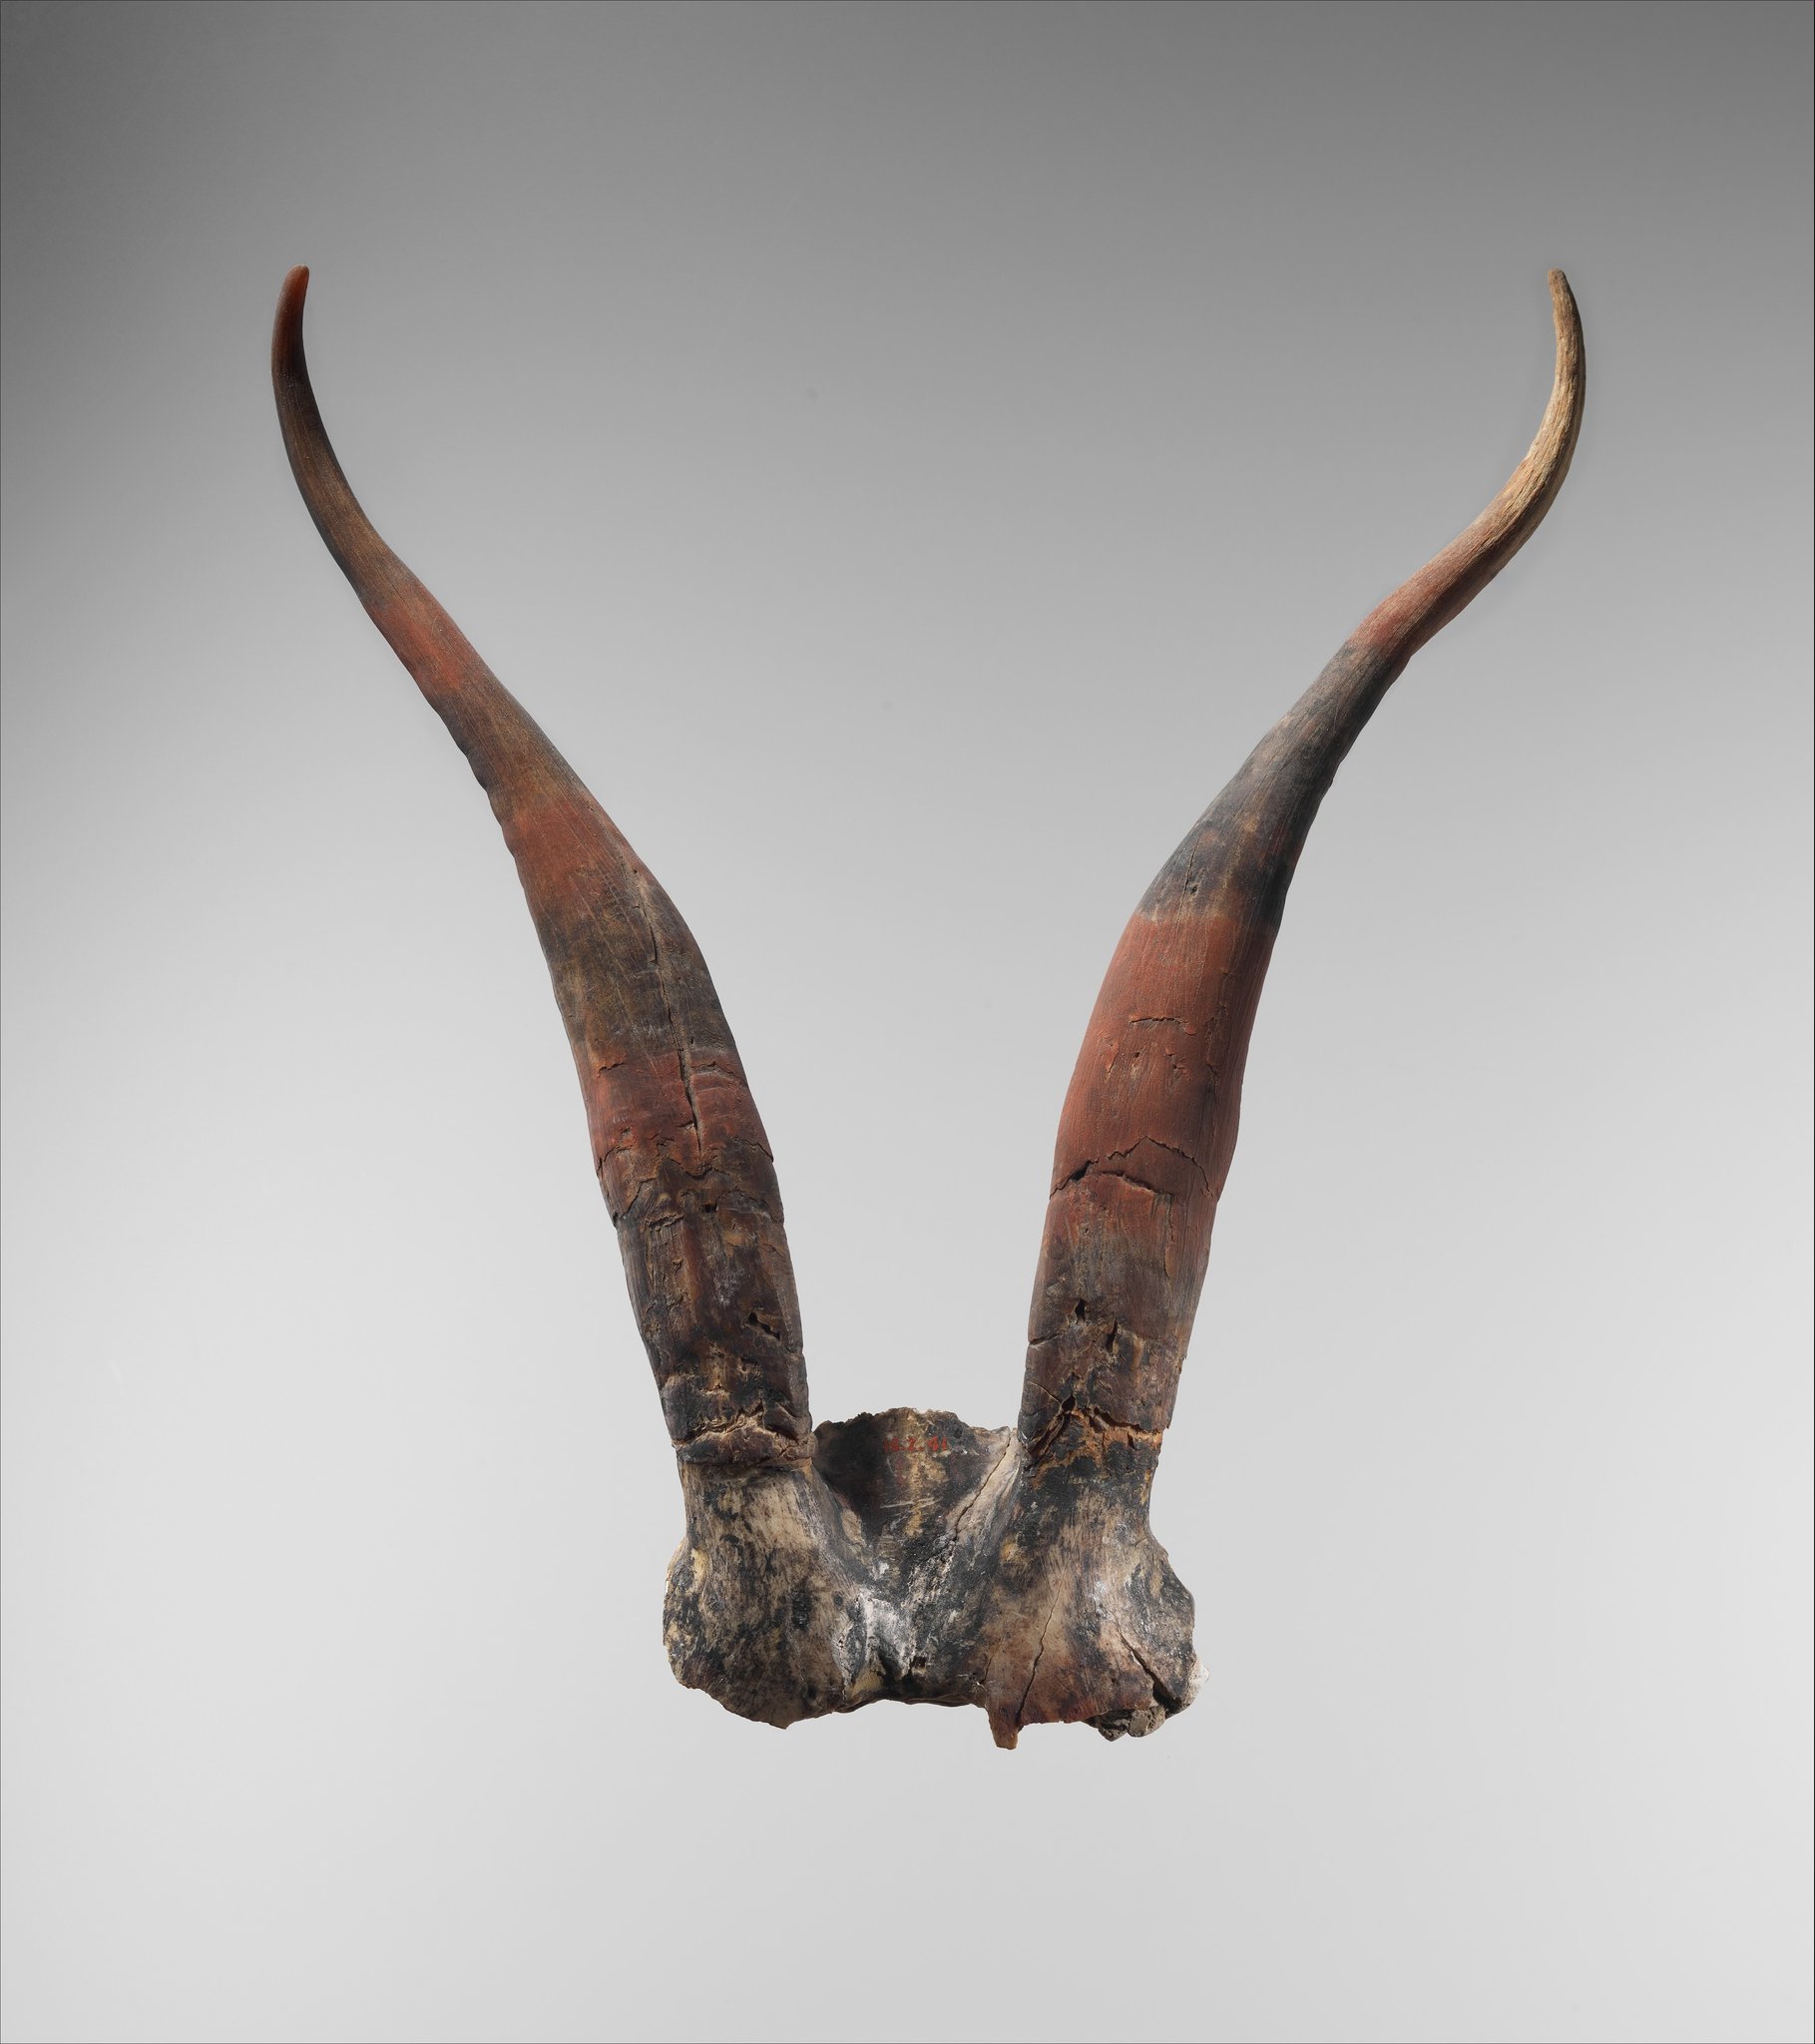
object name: bucranium, antler, horn, pan grave, medjayu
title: Bucrania skulls with antlers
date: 1640-1550 BCE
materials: antler, bone, paint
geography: egypt and sudan